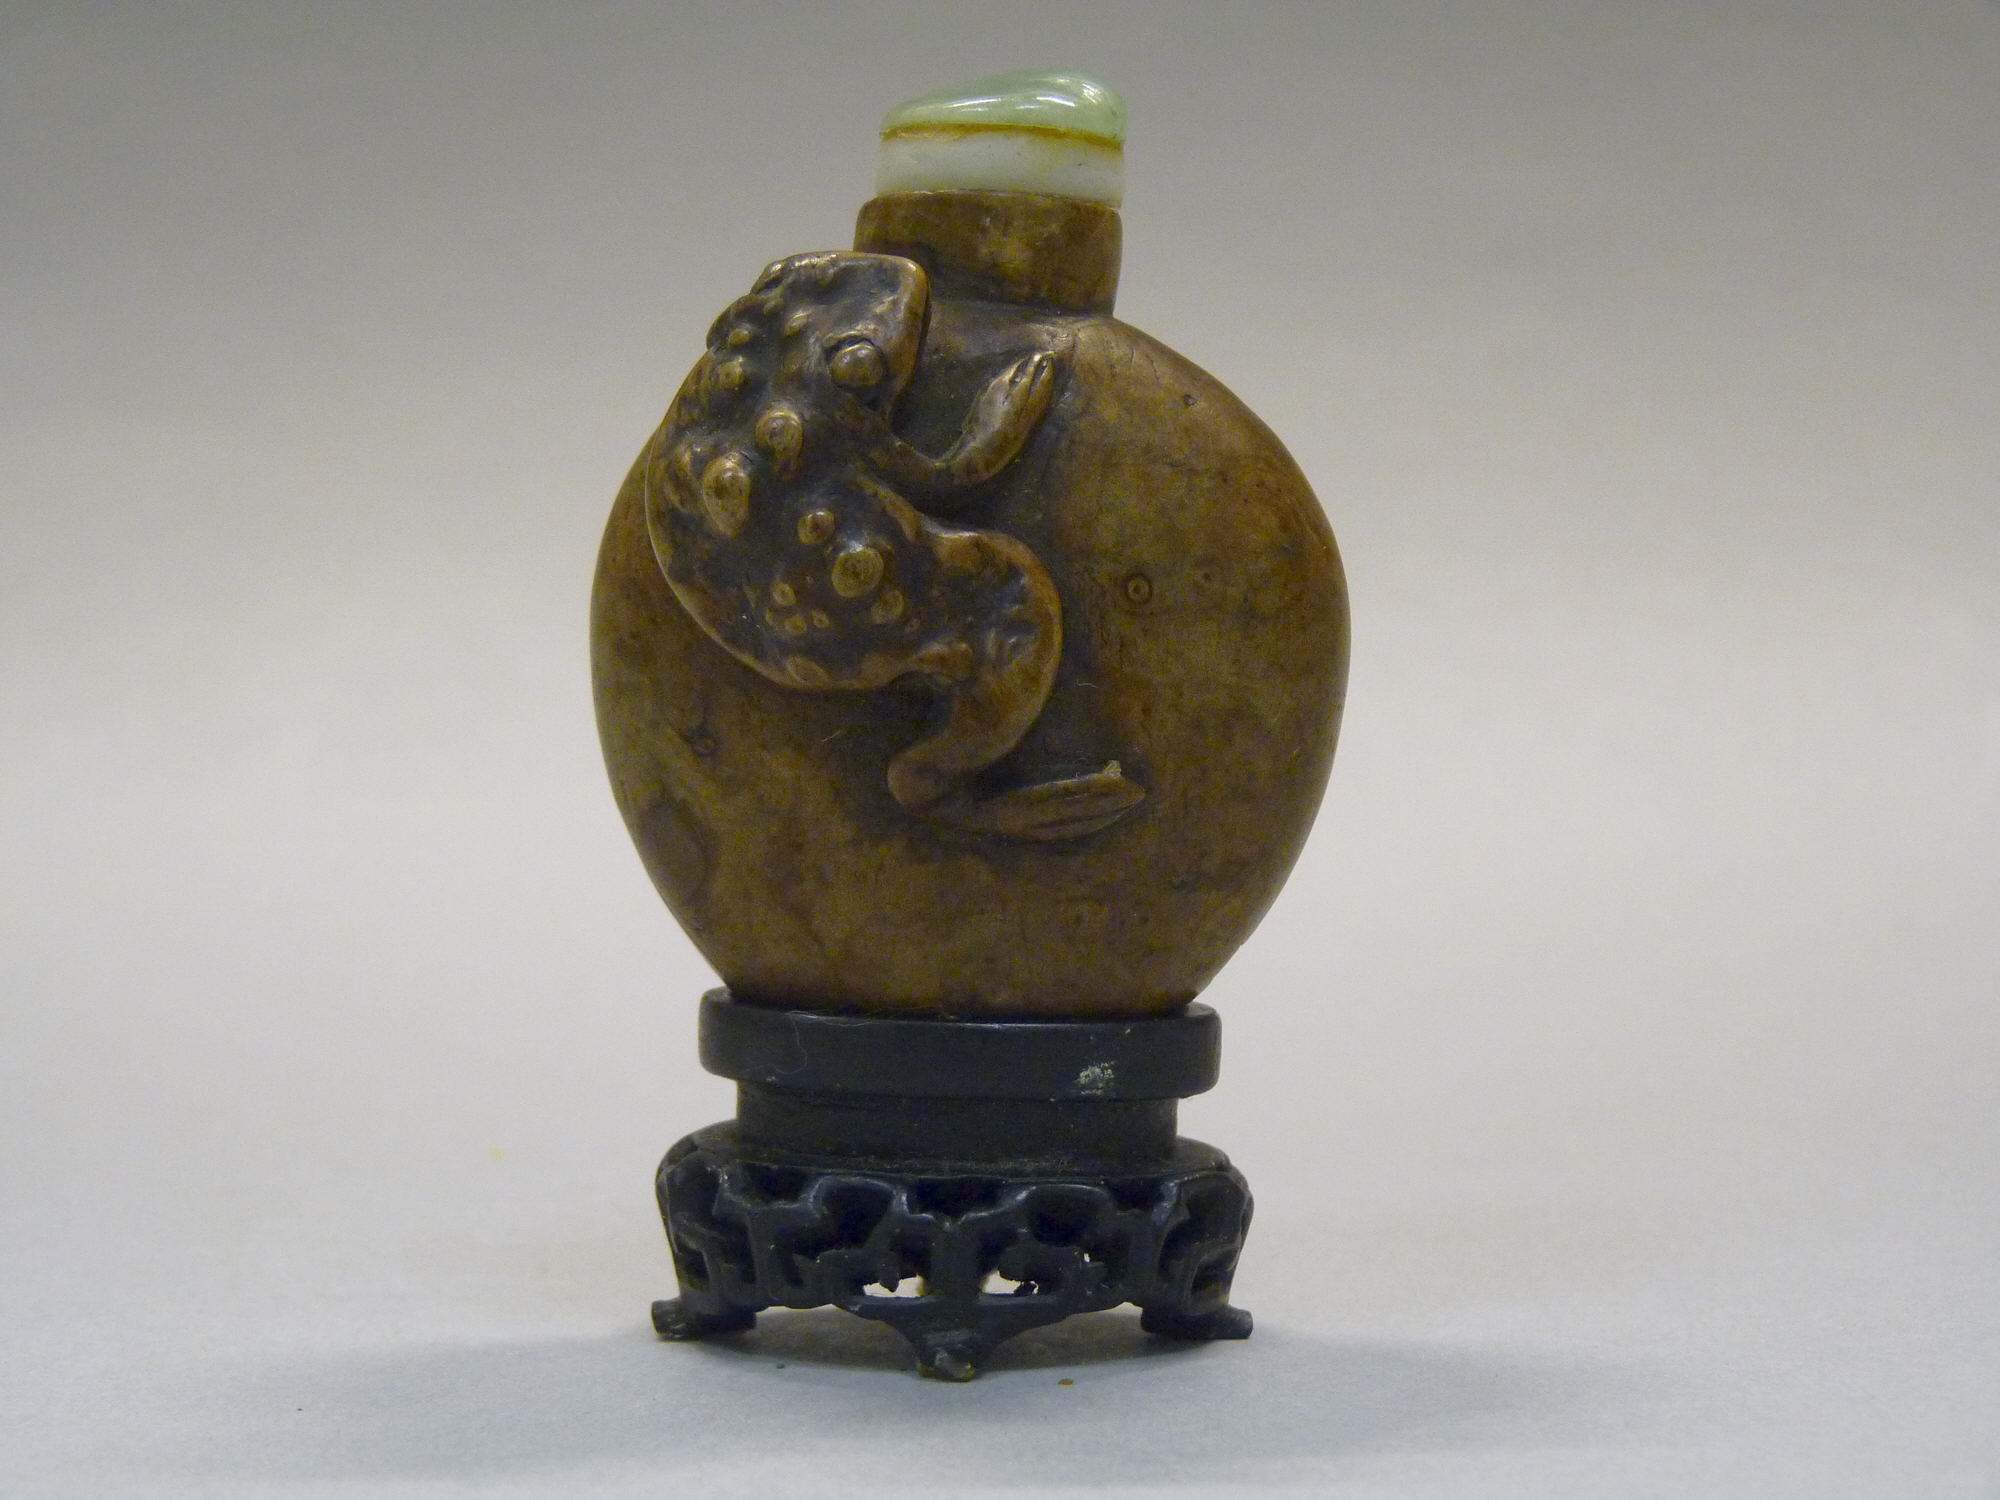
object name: snuff bottle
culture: chinese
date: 1736-1795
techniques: carving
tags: frogs